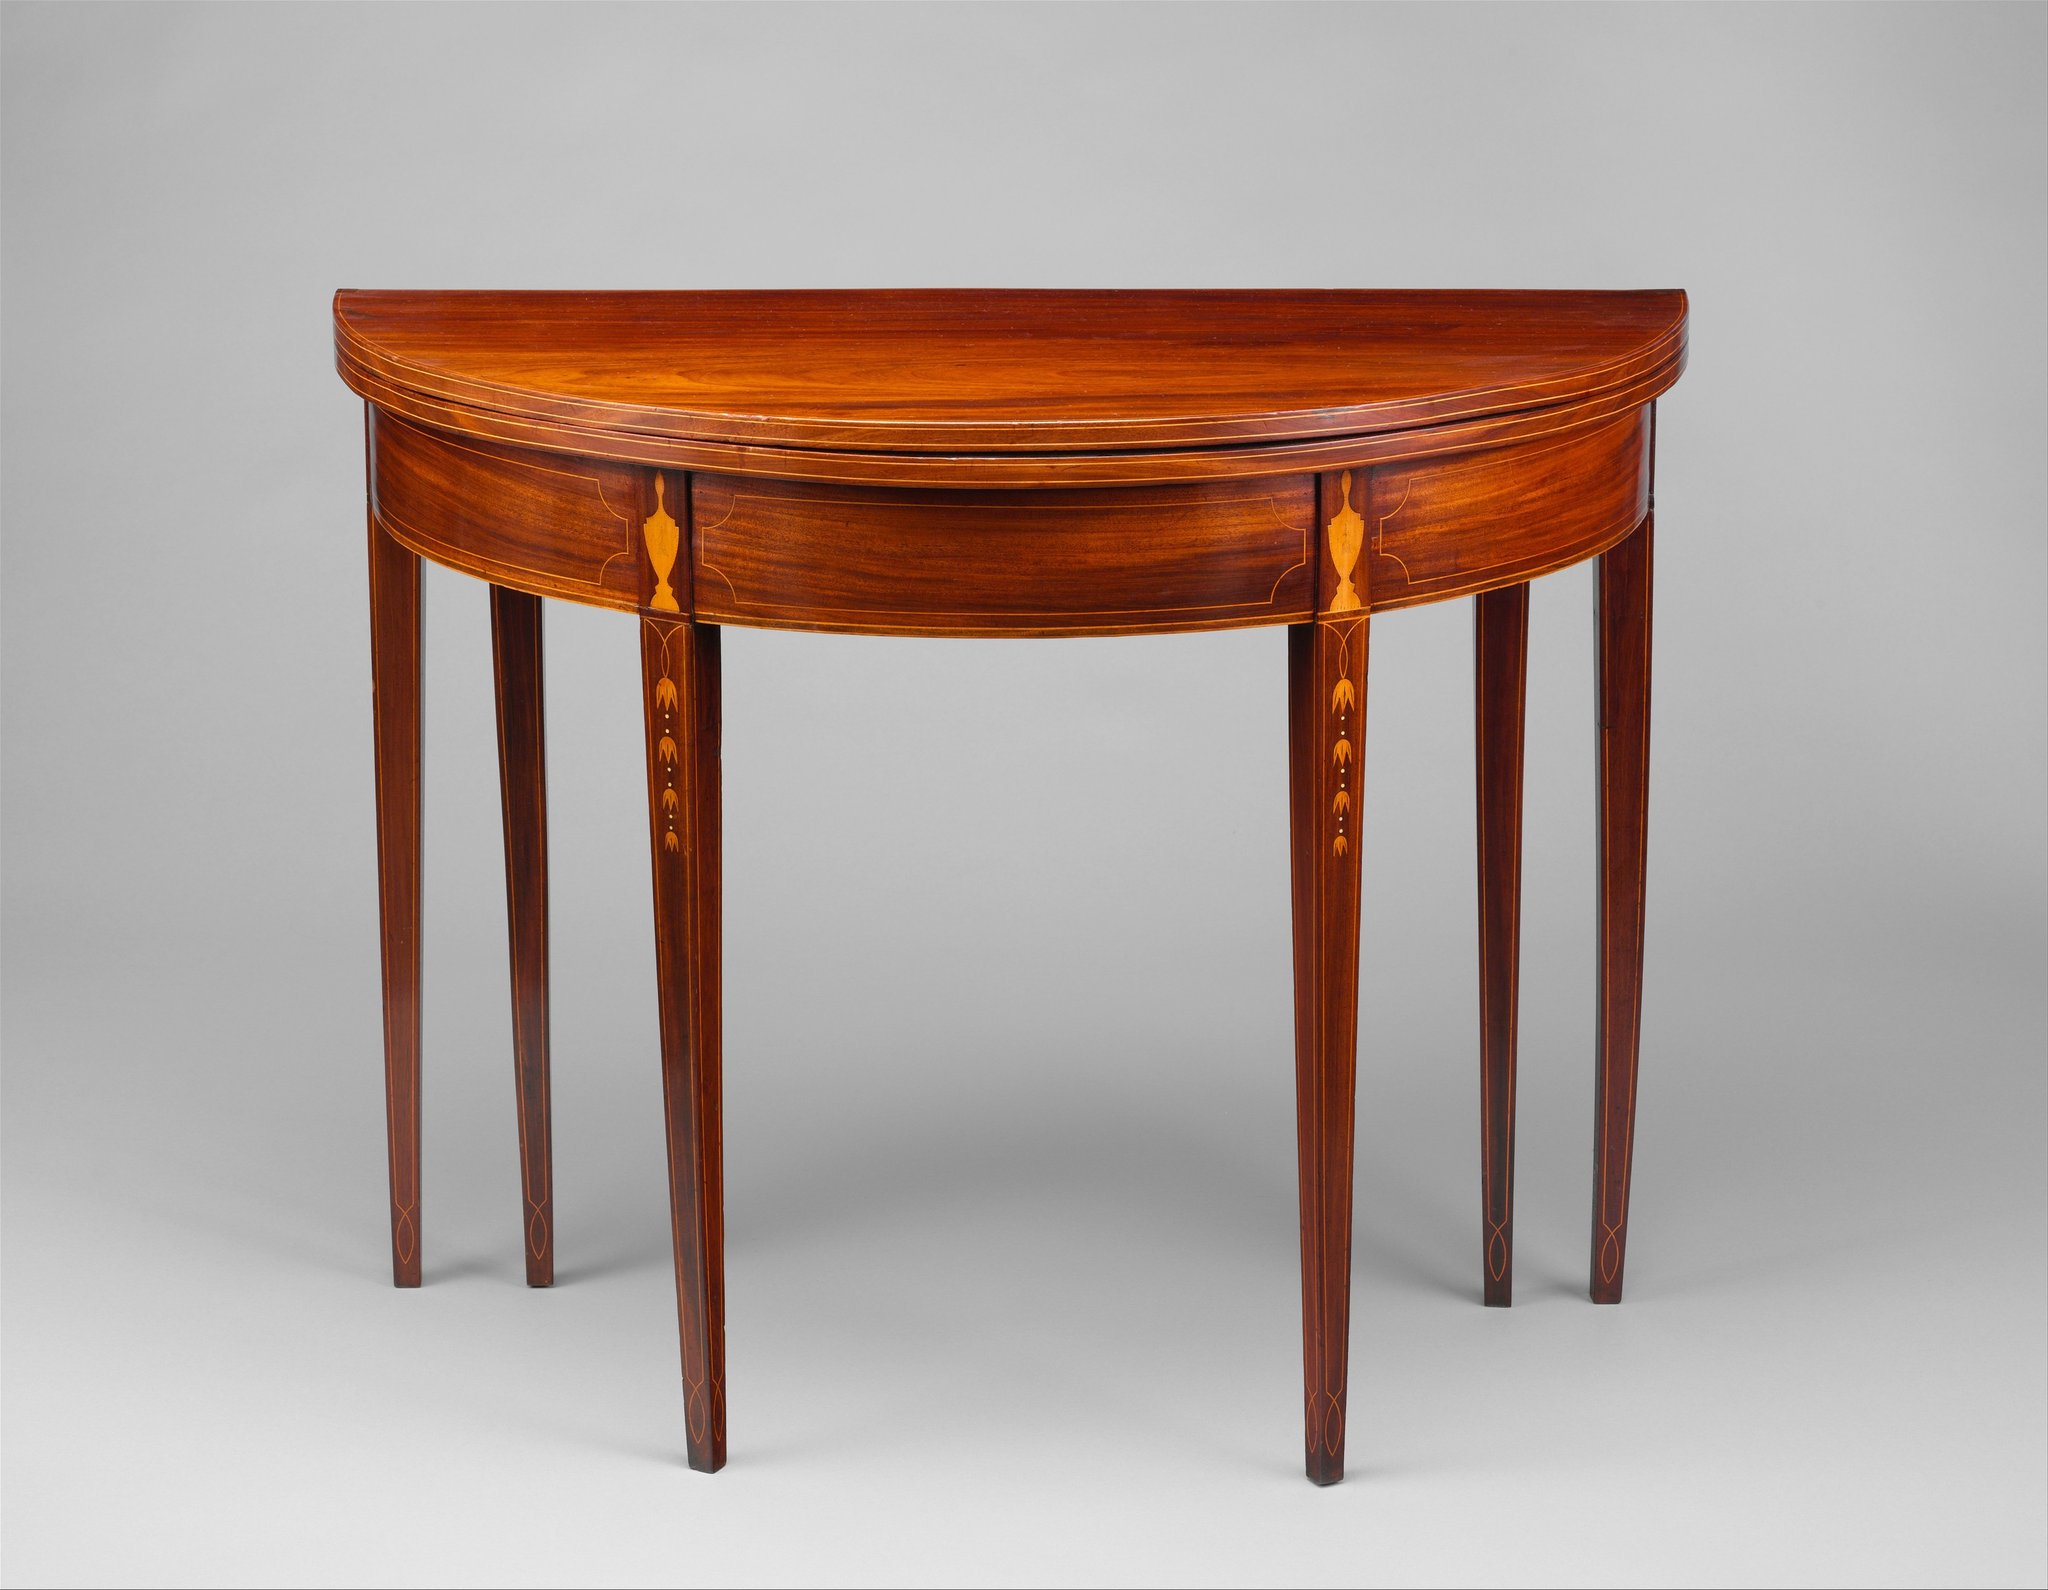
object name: card table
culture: american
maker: stephen goddard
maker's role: maker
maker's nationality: american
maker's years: 1764-1804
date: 1790-1804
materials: wood, ivory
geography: united states